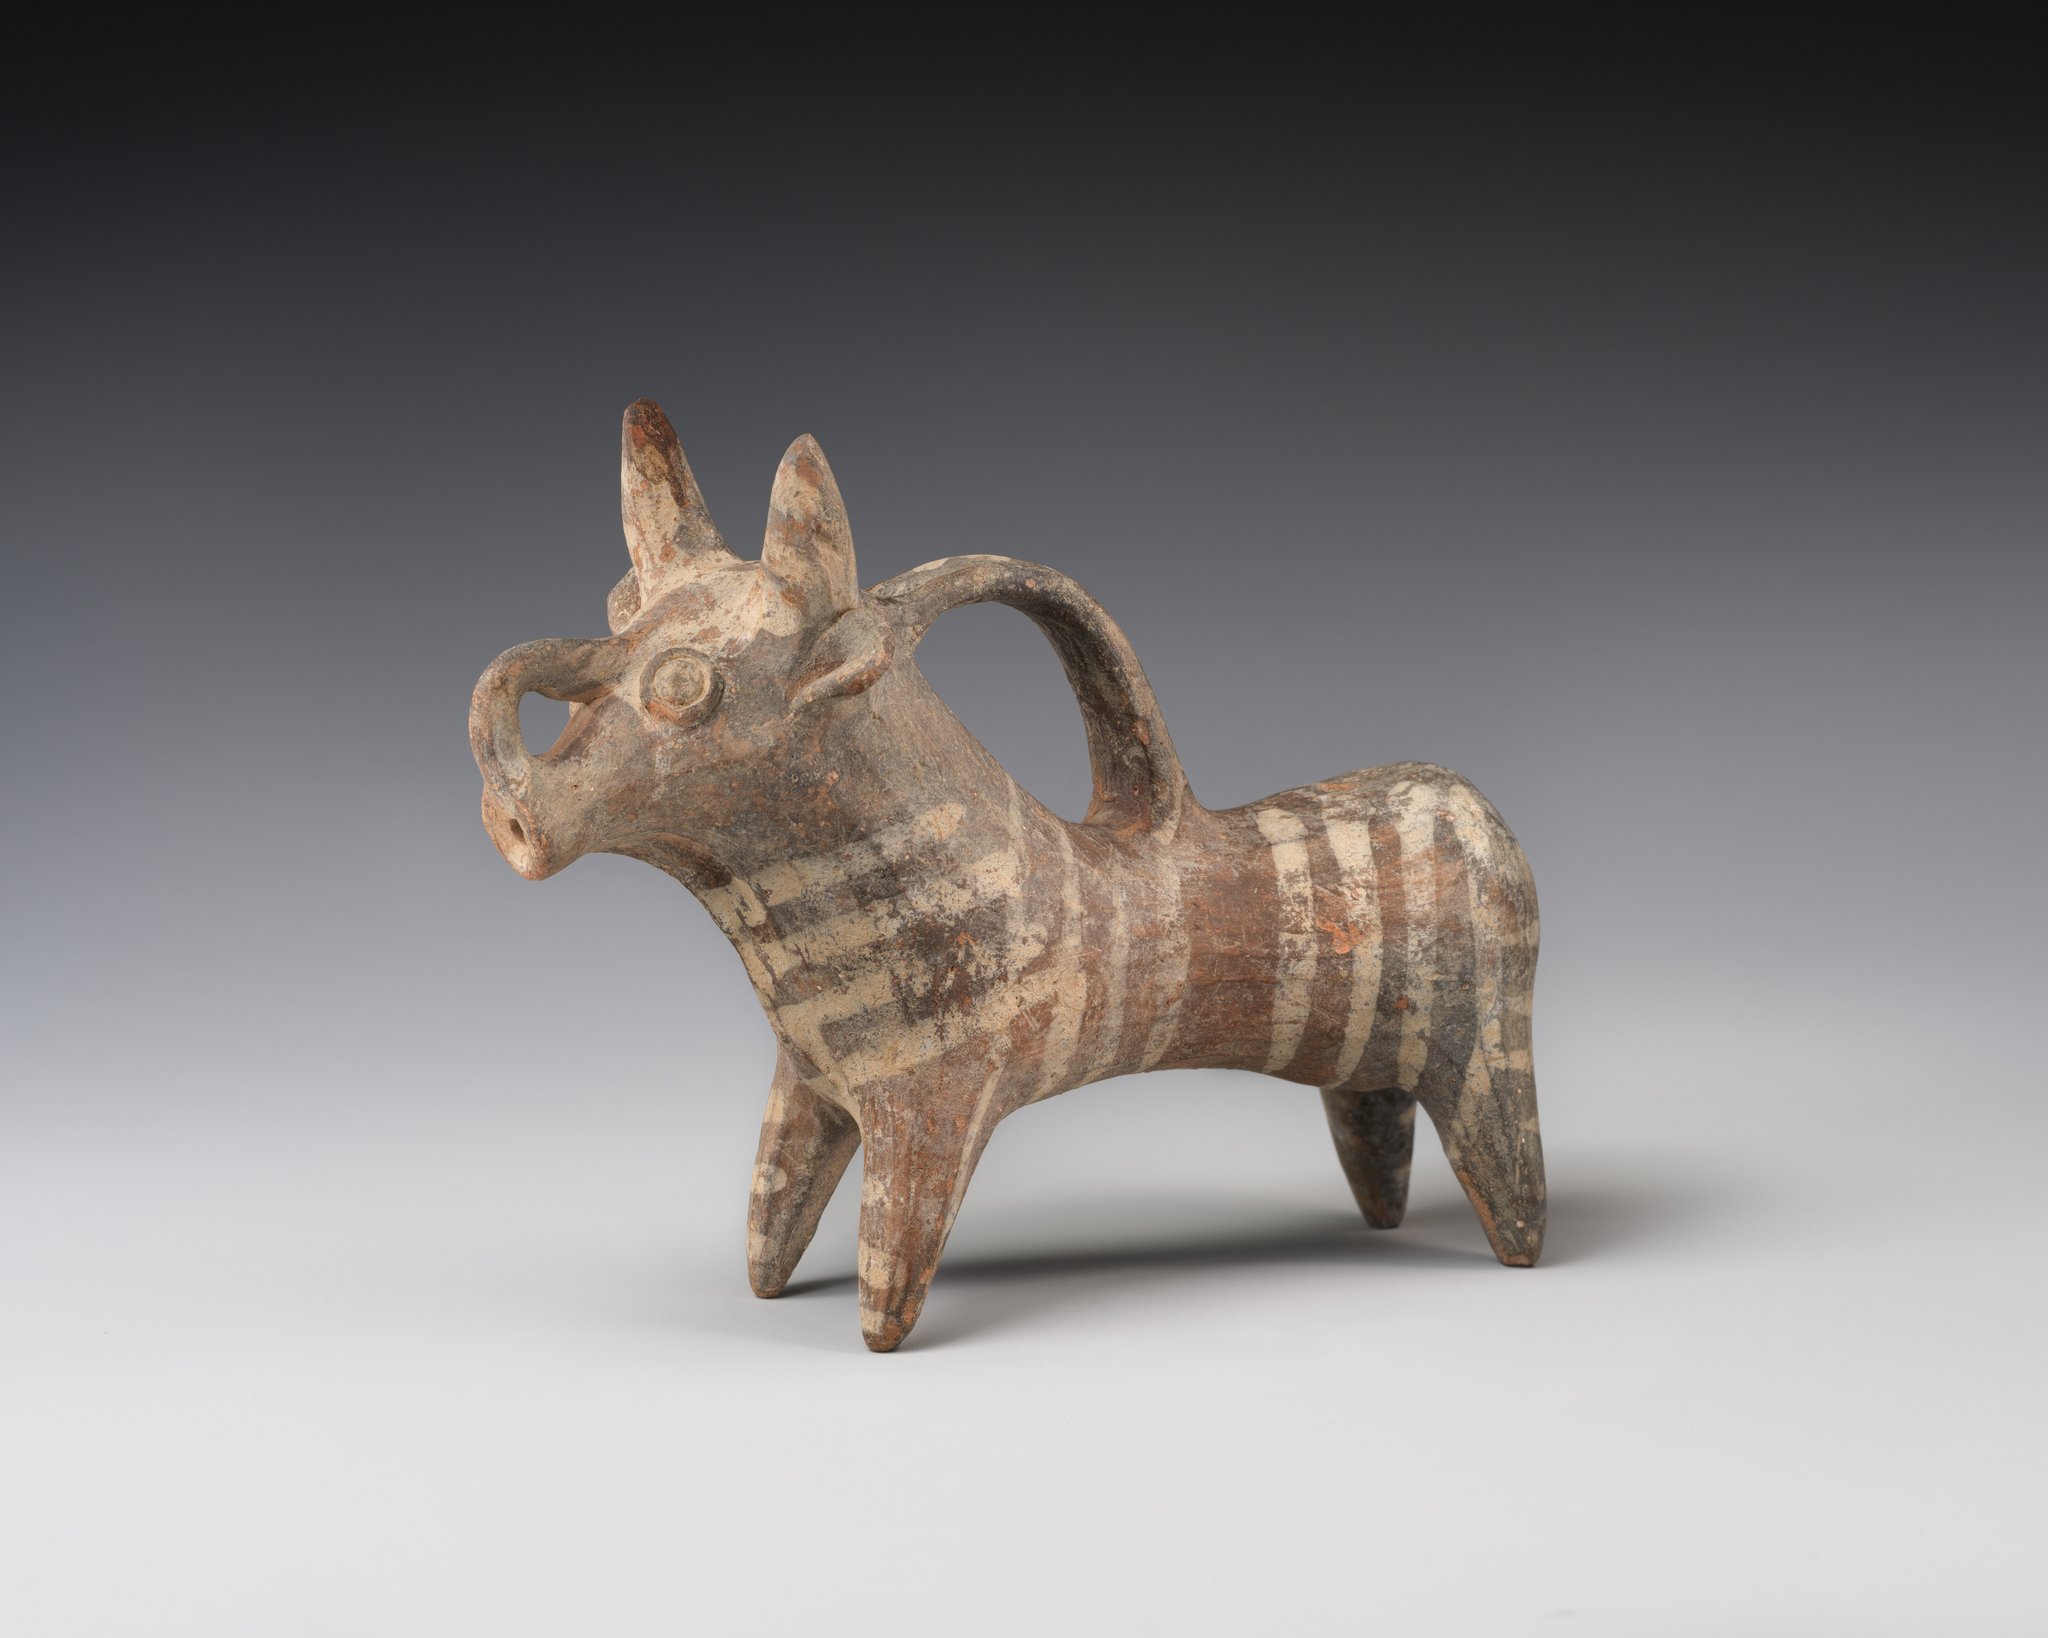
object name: vase in the form of a bull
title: Terracotta vase in the form of a bull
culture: cypriot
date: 1450-1200 BCE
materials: terracotta